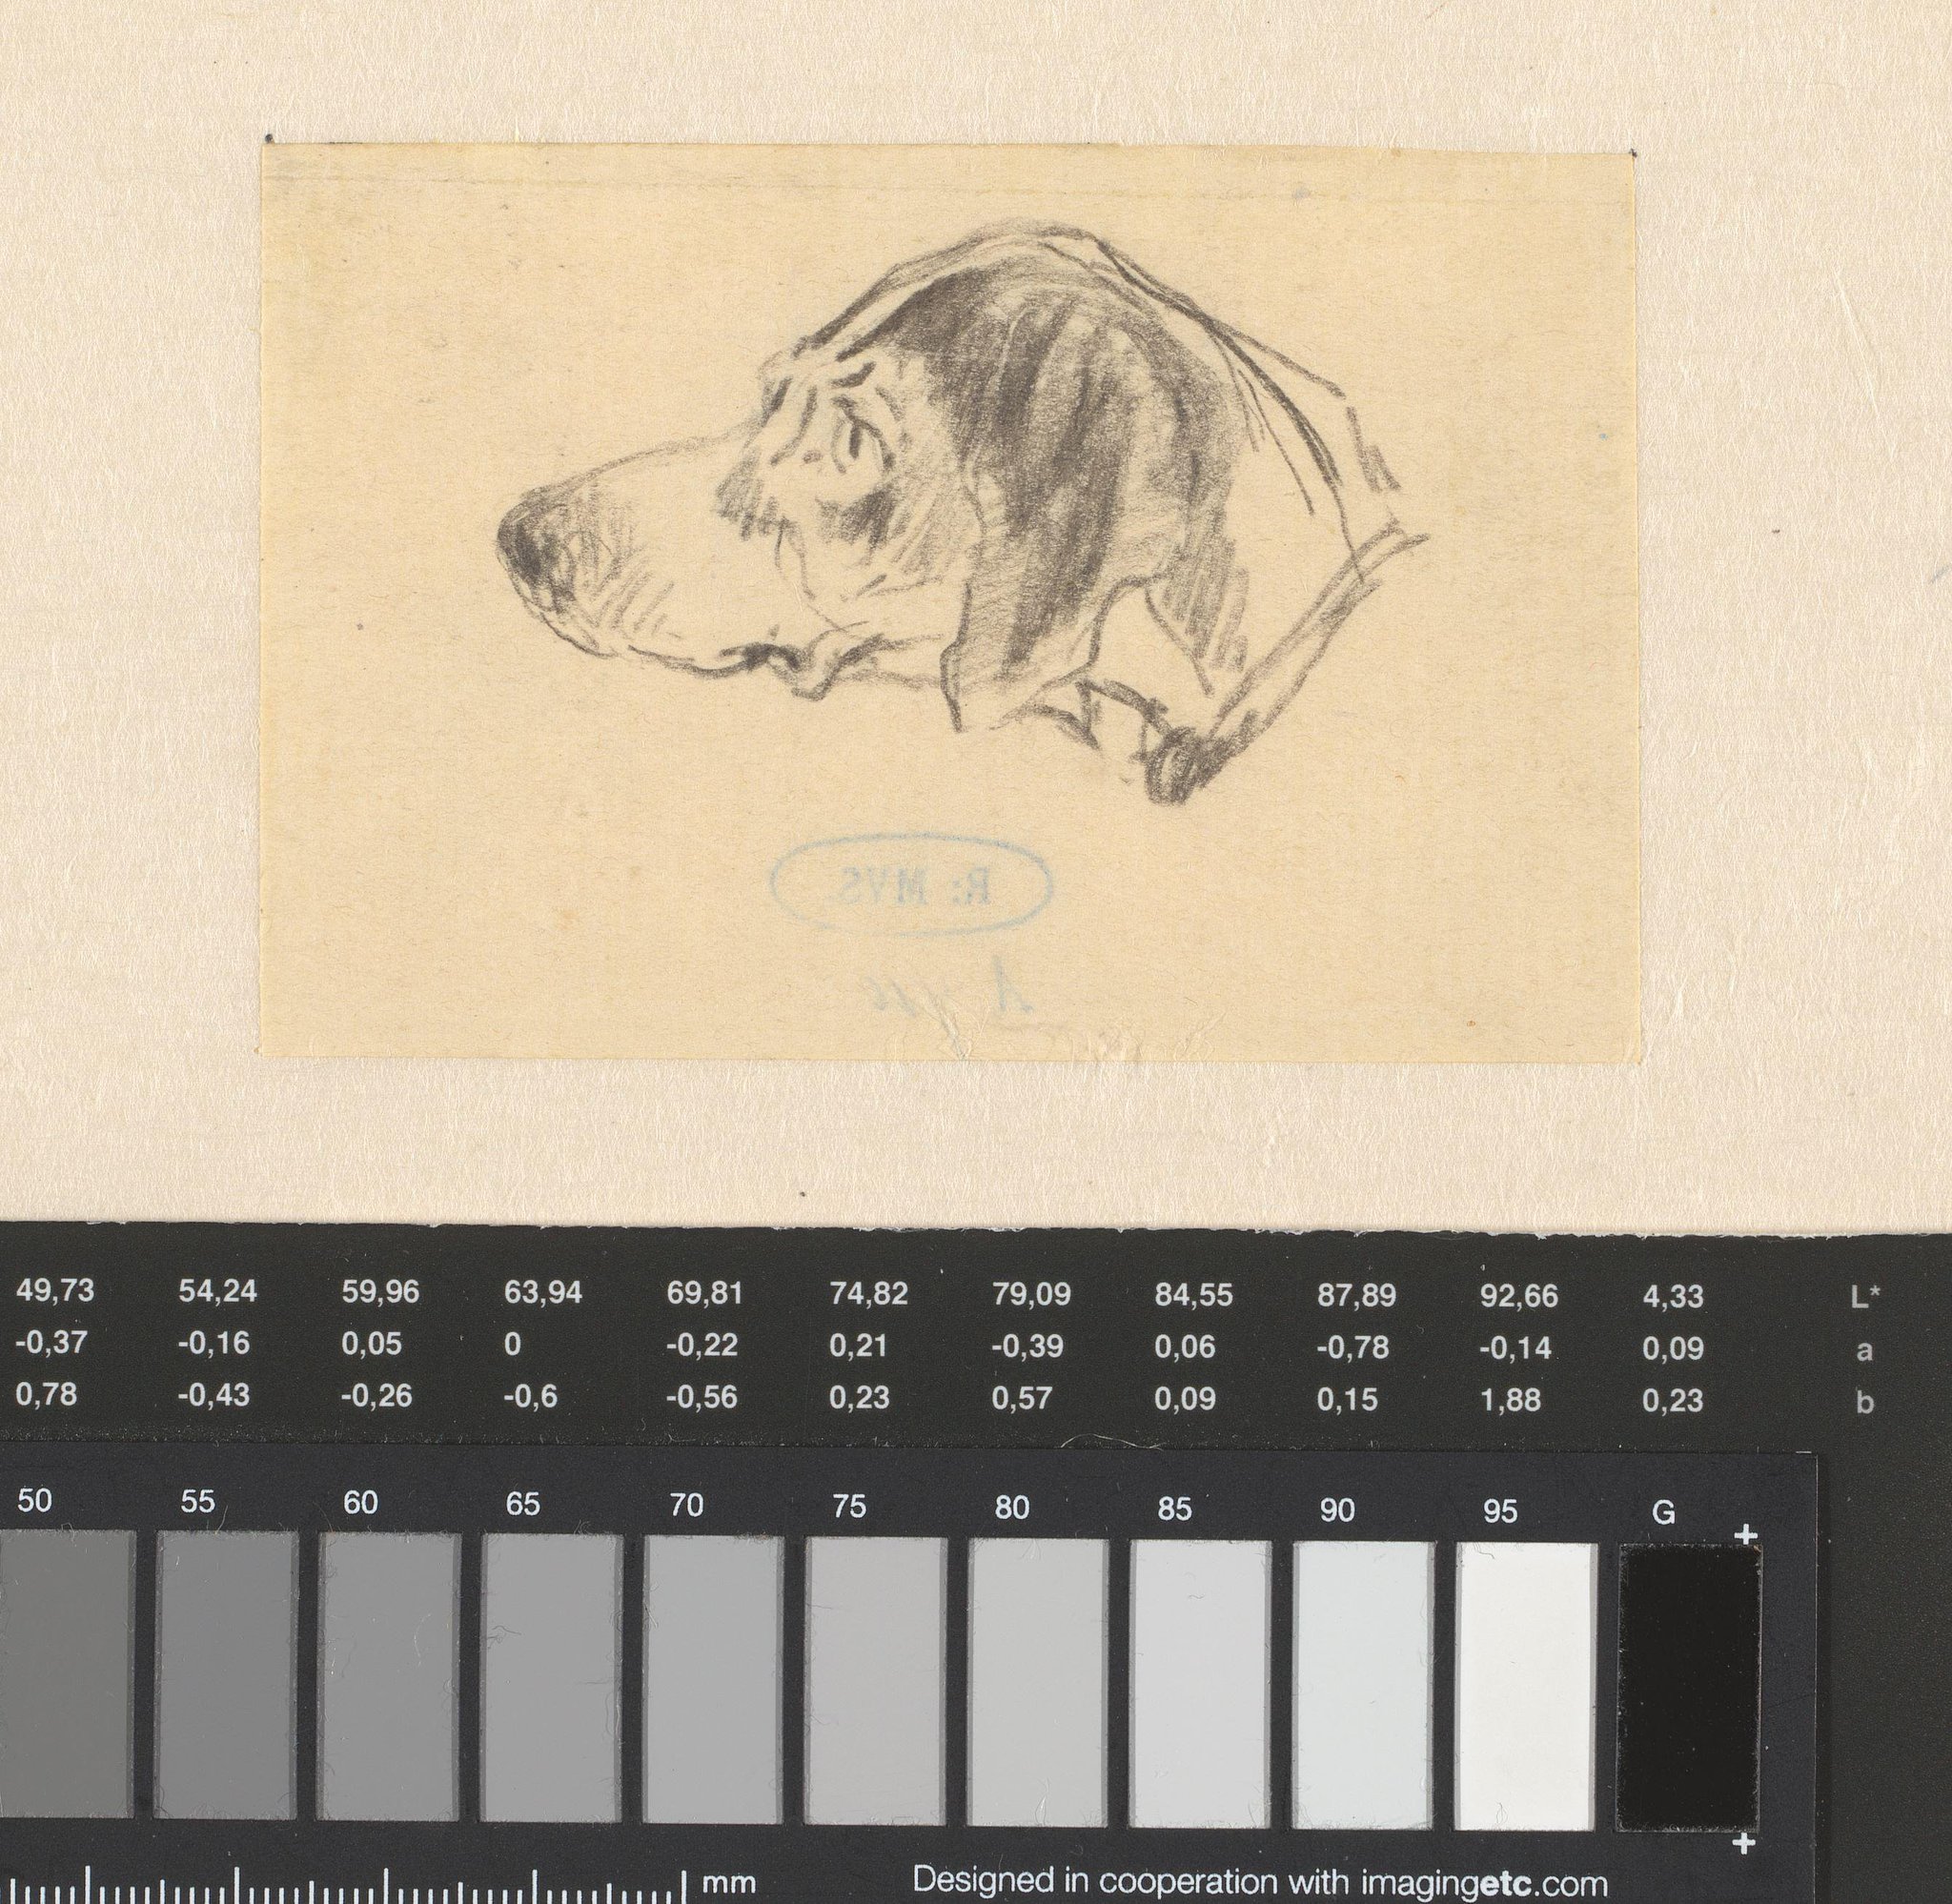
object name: drawing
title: Kop van een jachthond, in profiel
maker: johan daniël koelman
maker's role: draughtsman, print maker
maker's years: 1831-1857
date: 1841-1857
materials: charcoal, paper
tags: dog (+ head of an animal)